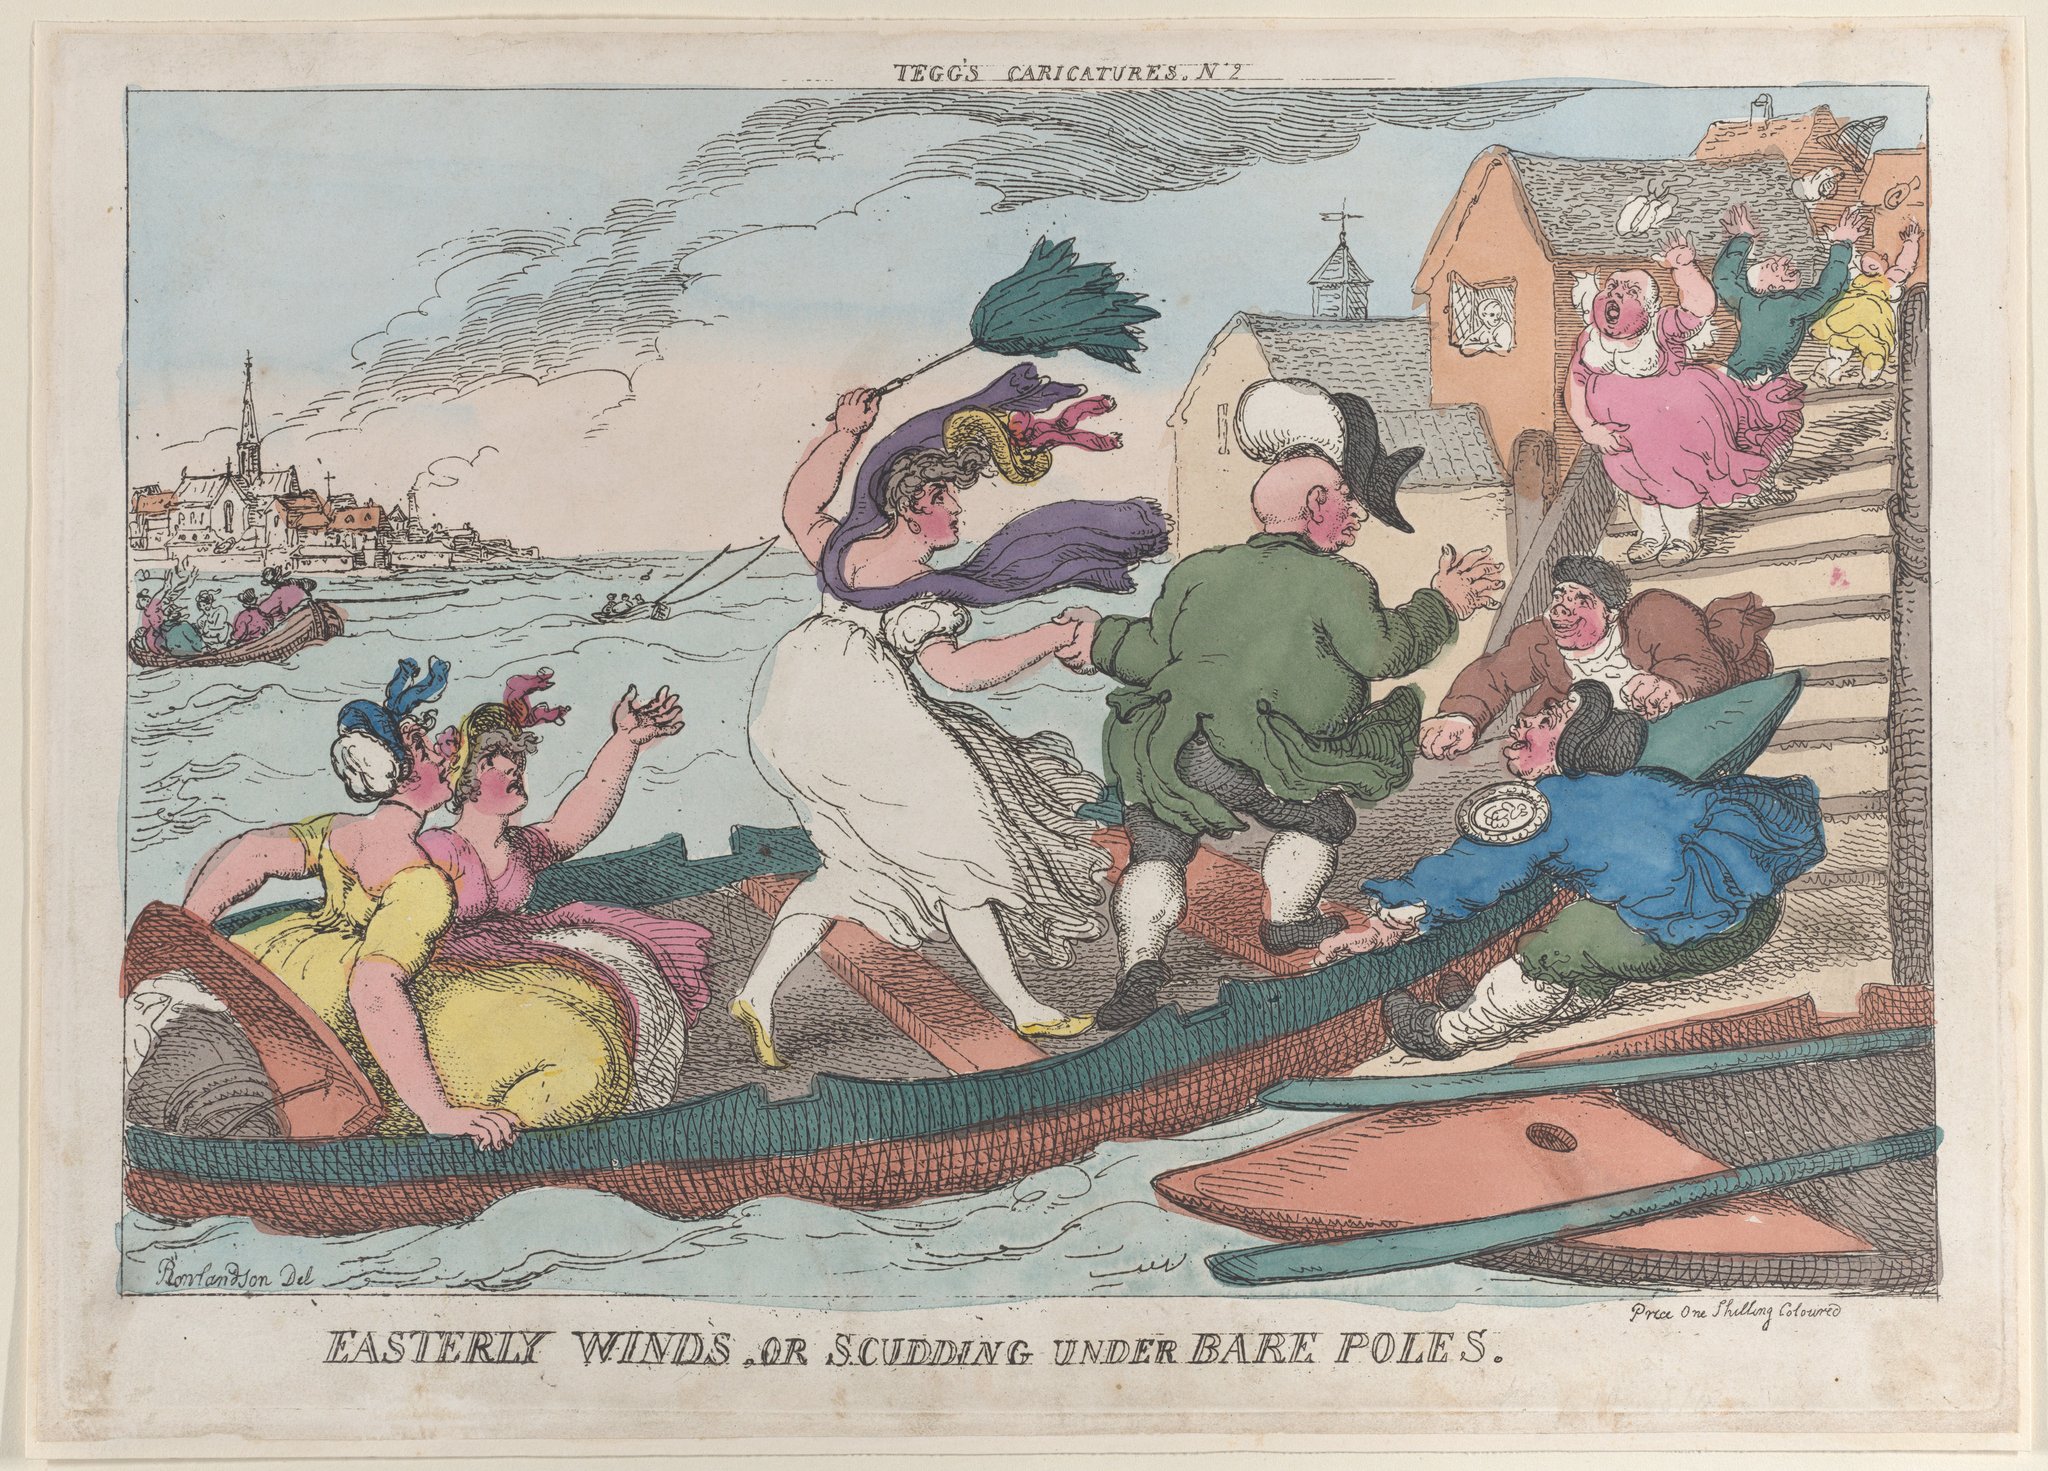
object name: print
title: Easterly Winds, or Scudding Under Bare Poles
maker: thomas rowlandson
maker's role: artist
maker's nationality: british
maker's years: 1757-1827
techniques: etching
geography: london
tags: satire,men,women,wind,boats